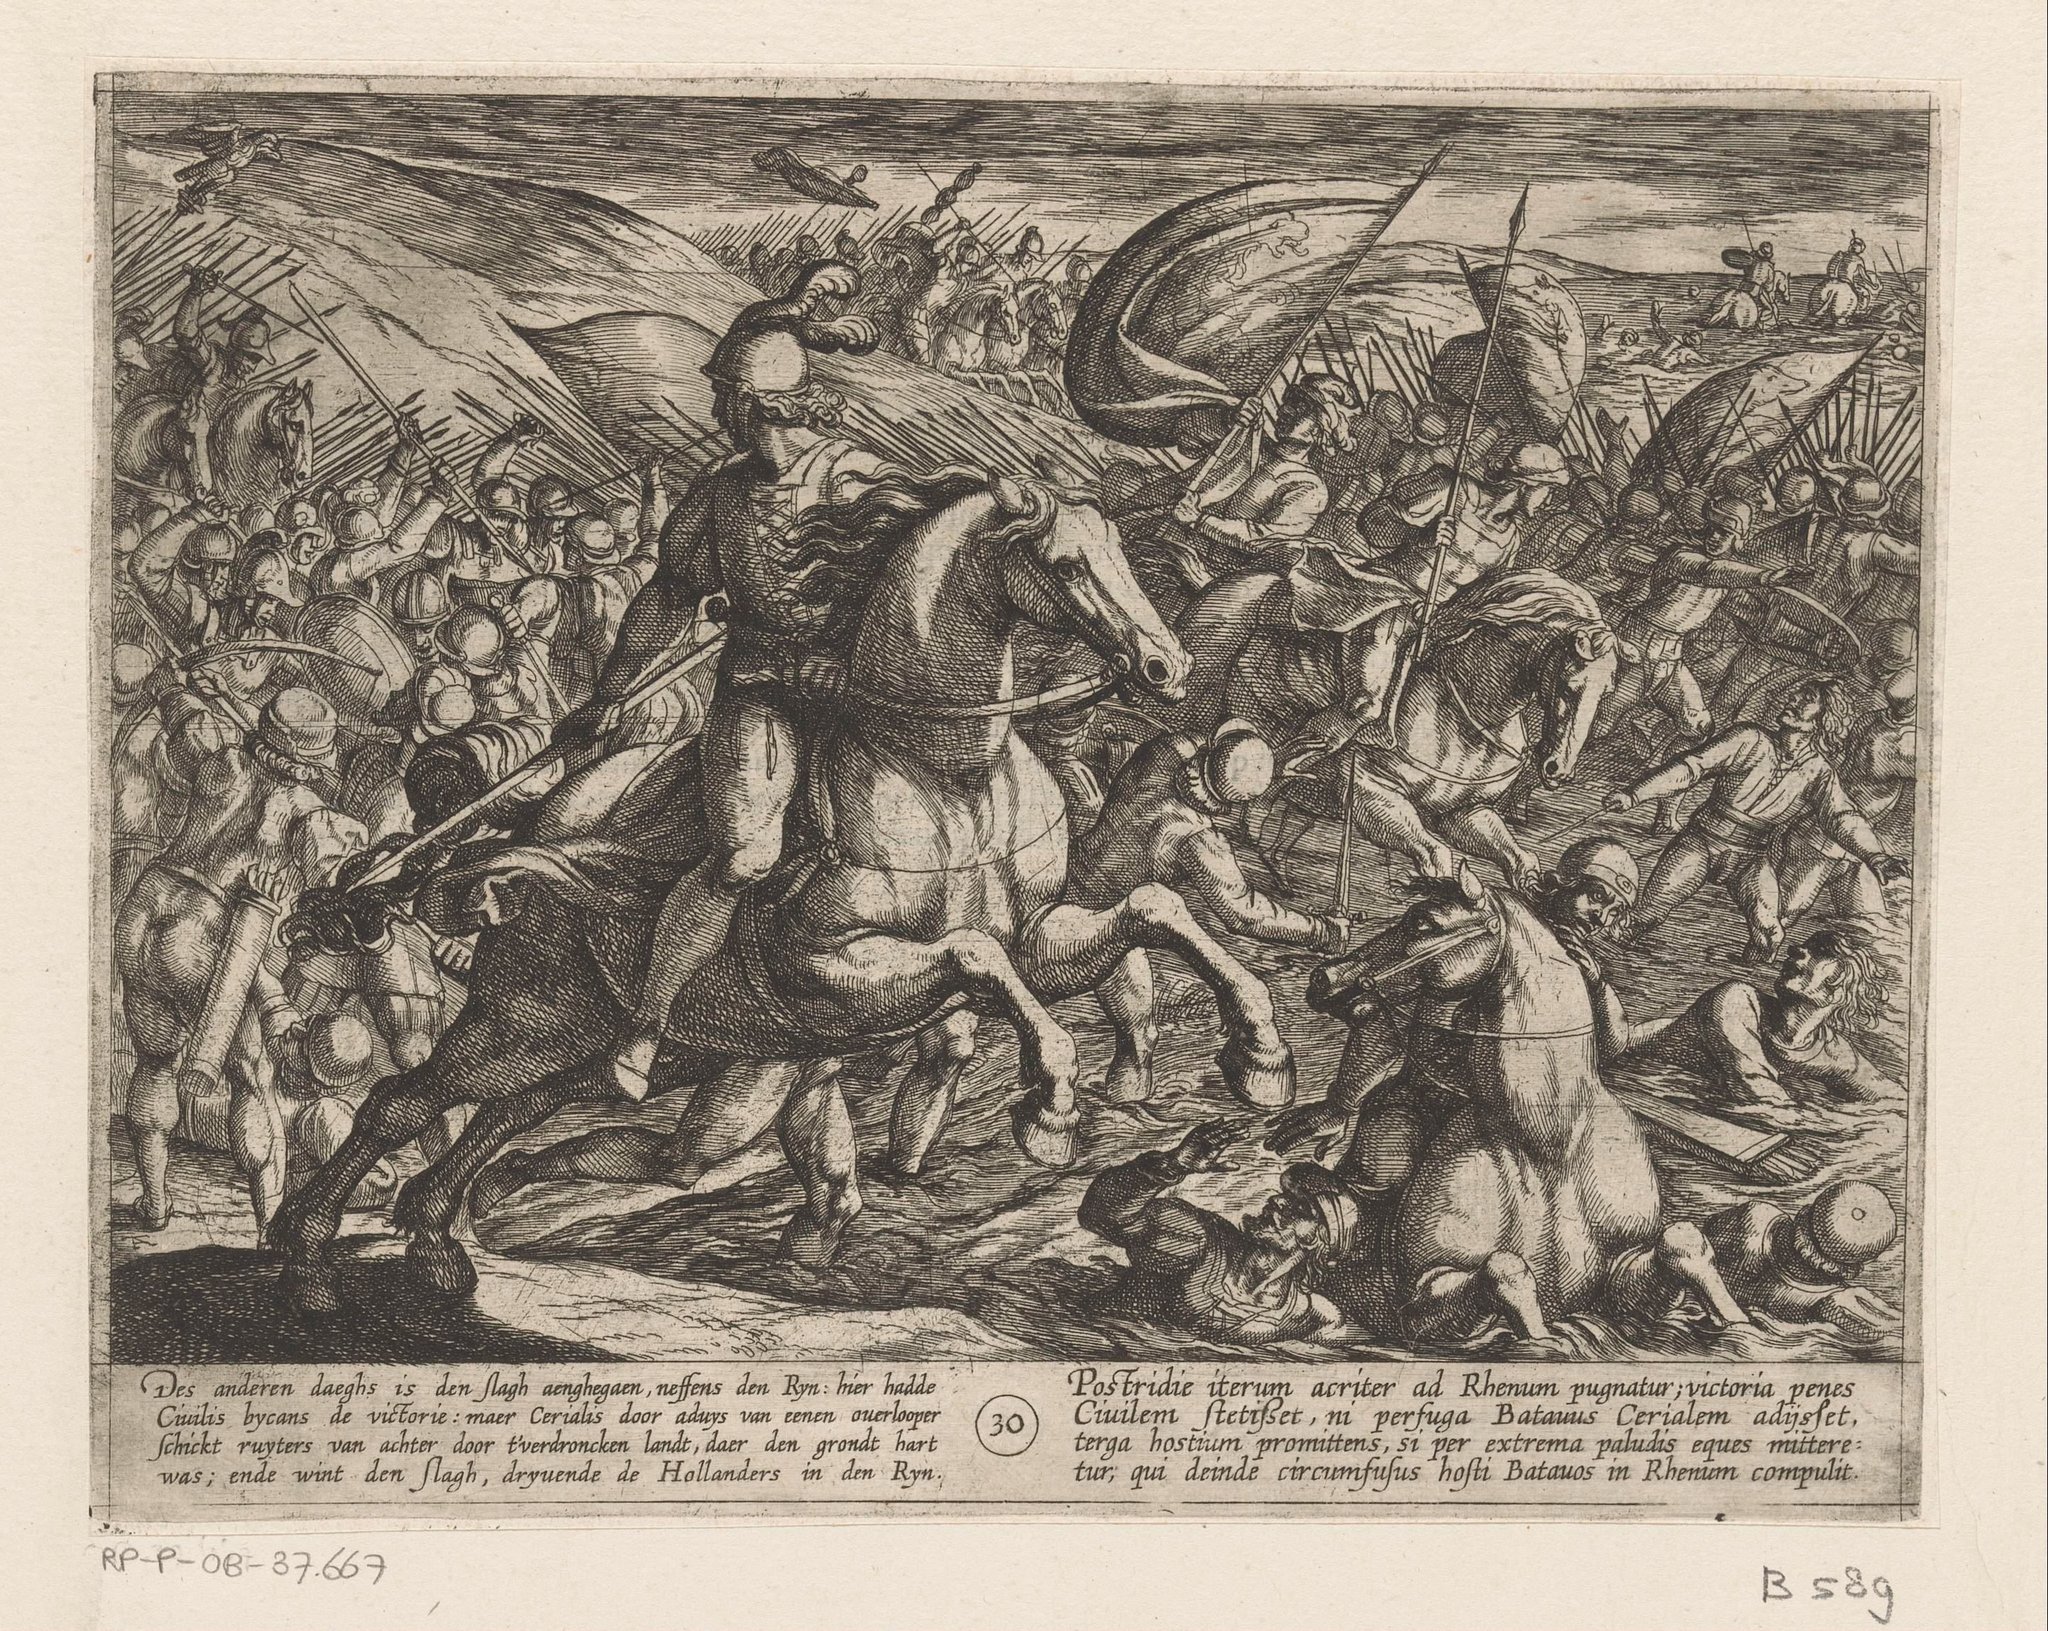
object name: print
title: De Bataafse oorlogen tegen de Romeinen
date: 1611-1612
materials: paper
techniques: etching, letterpress printing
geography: antwerp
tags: battle, the soldier; the soldier's life, extinct, 'historical' peoples (with name)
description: Cerialis en zijn Romeinse leger drijven de Nederlandse soldaten in de rivier de Rijn. Onderschrift in het Nederlands en in het Latijn.